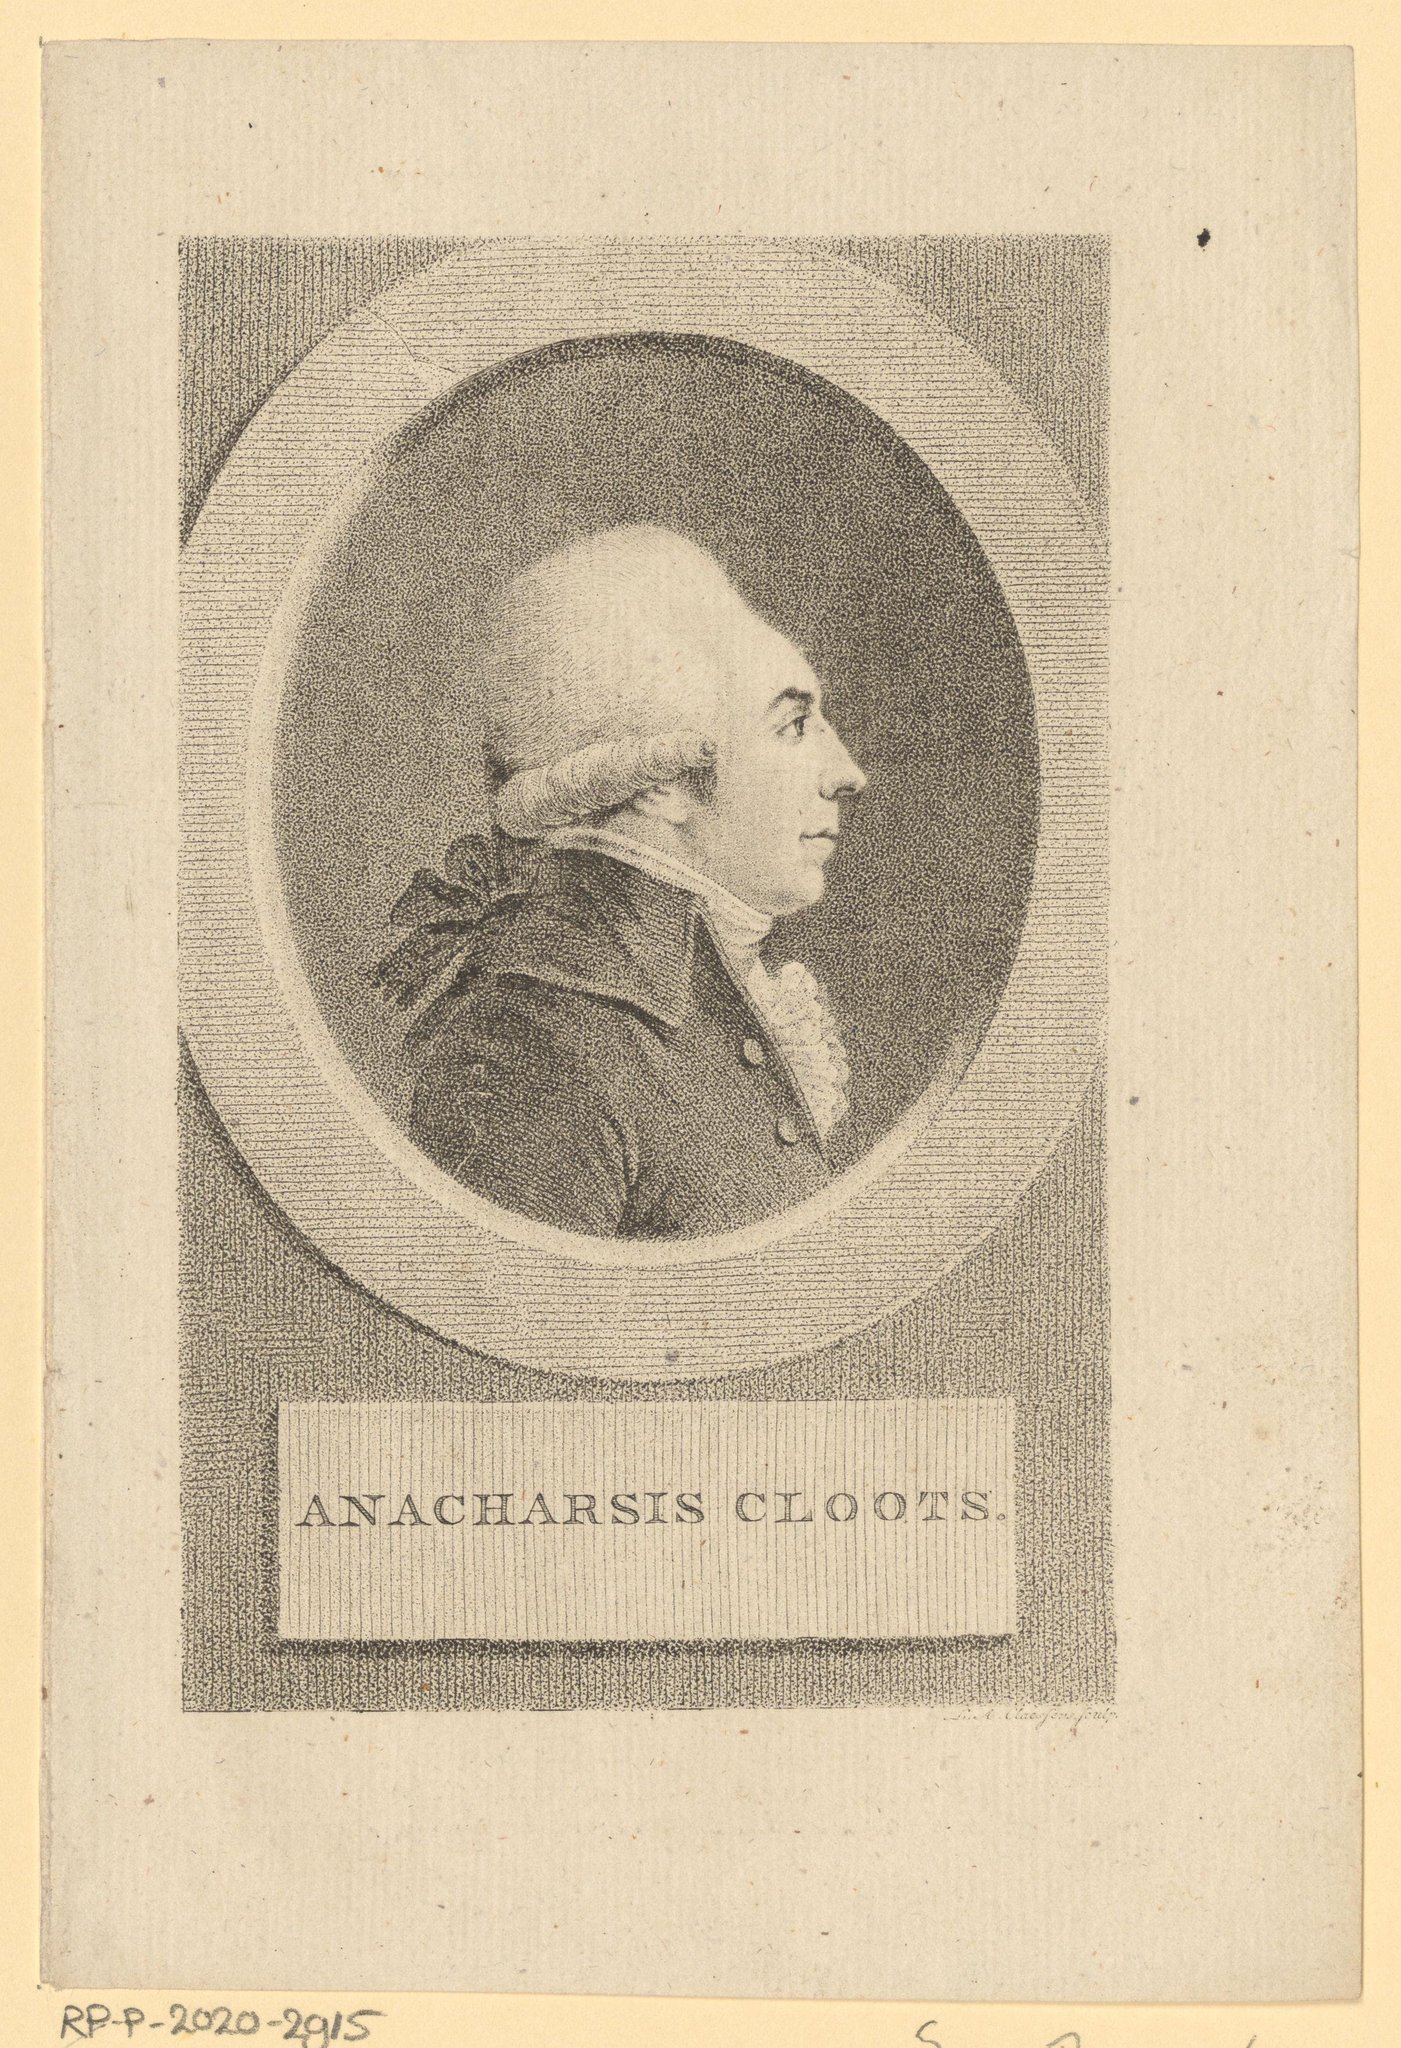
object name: print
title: Portret van Jean Baptiste baron de Cloots du Val-de-Grâce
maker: lambertus antonius claessens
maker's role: draughtsman, print maker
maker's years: 1763-1834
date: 1798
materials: paper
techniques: etching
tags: cleves, paris, politician, historical persons, politician, e.g. party leader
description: Prent mogelijk uit: Tafereelen van de staatsomwenteling in Frankrijk. Amsterdam: Johannes Allart, 1798, dl. 6, tussen p. 204 en 205.